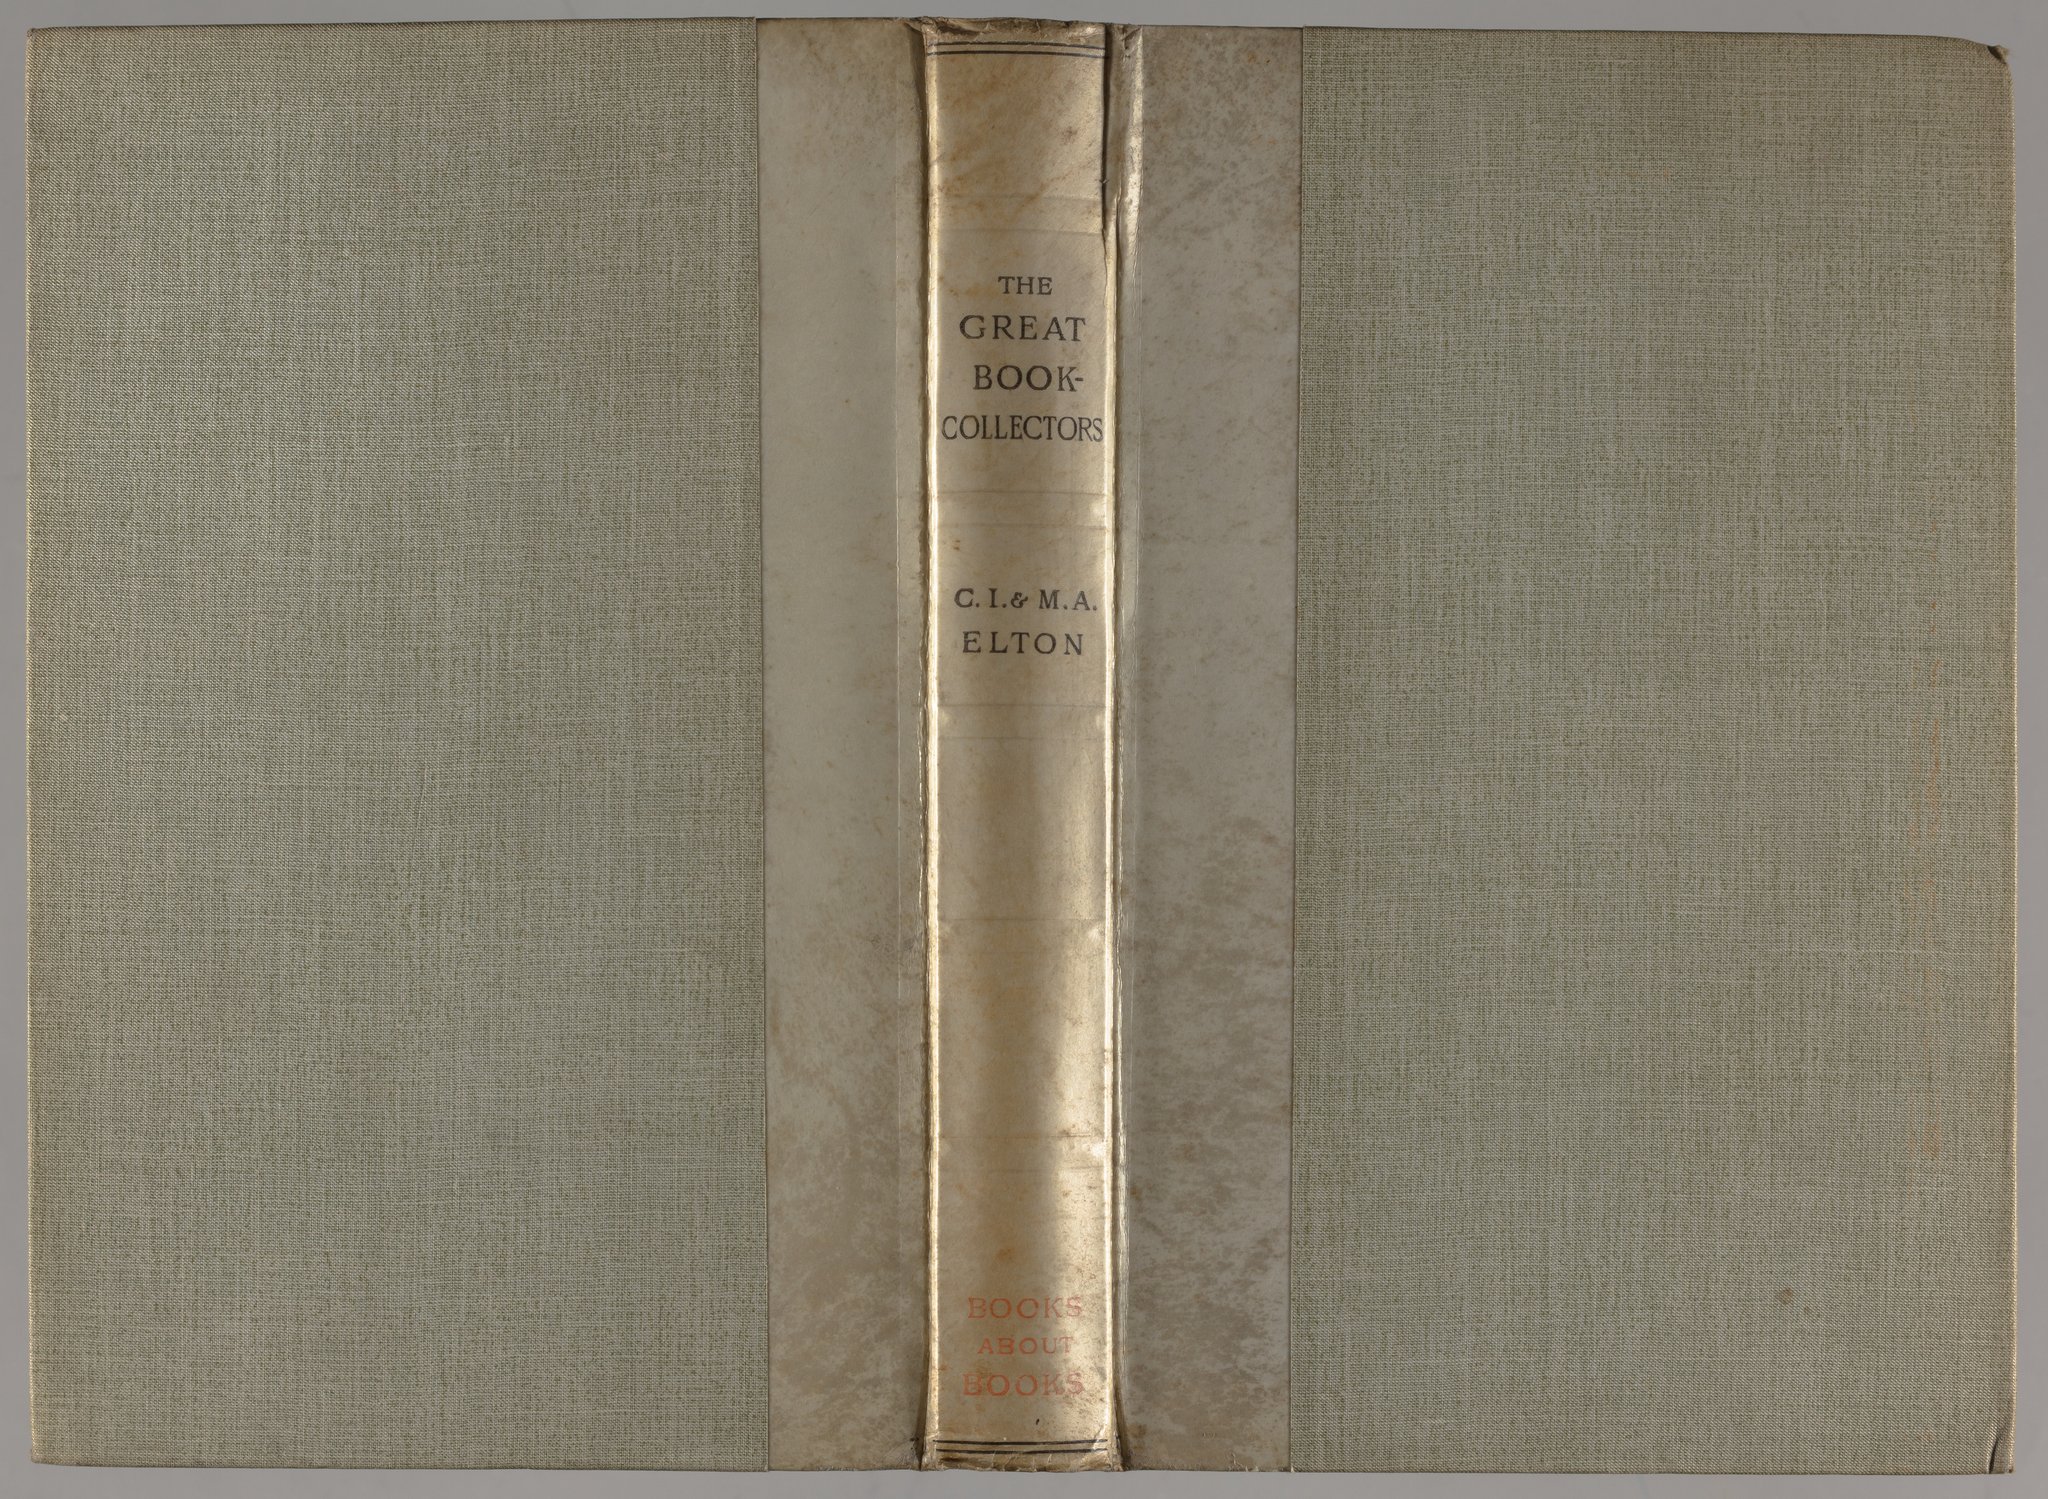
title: The great book-collectors / by Charles Isaac Elton & Mary Augusta Elton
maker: charles isaac elton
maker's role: author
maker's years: 1839-1900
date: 1893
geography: england